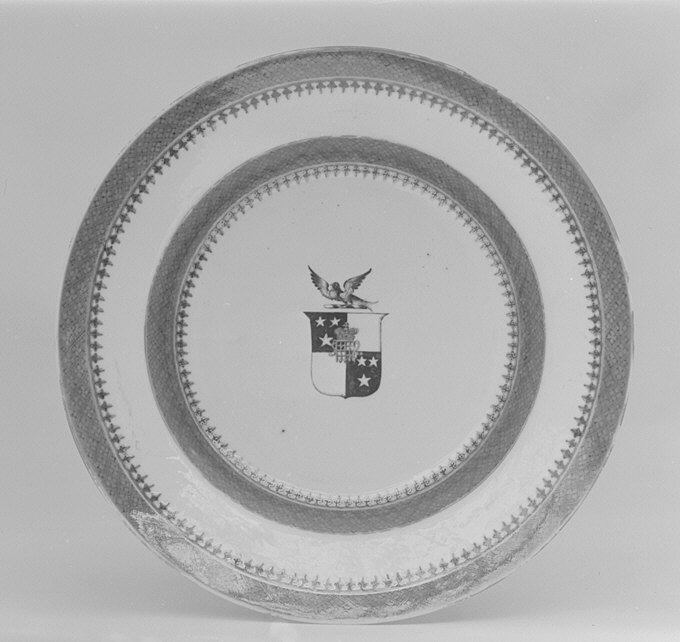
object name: soup plate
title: Soup plate (part of a service)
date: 1790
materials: hard paste porcelain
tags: birds,coat of arms